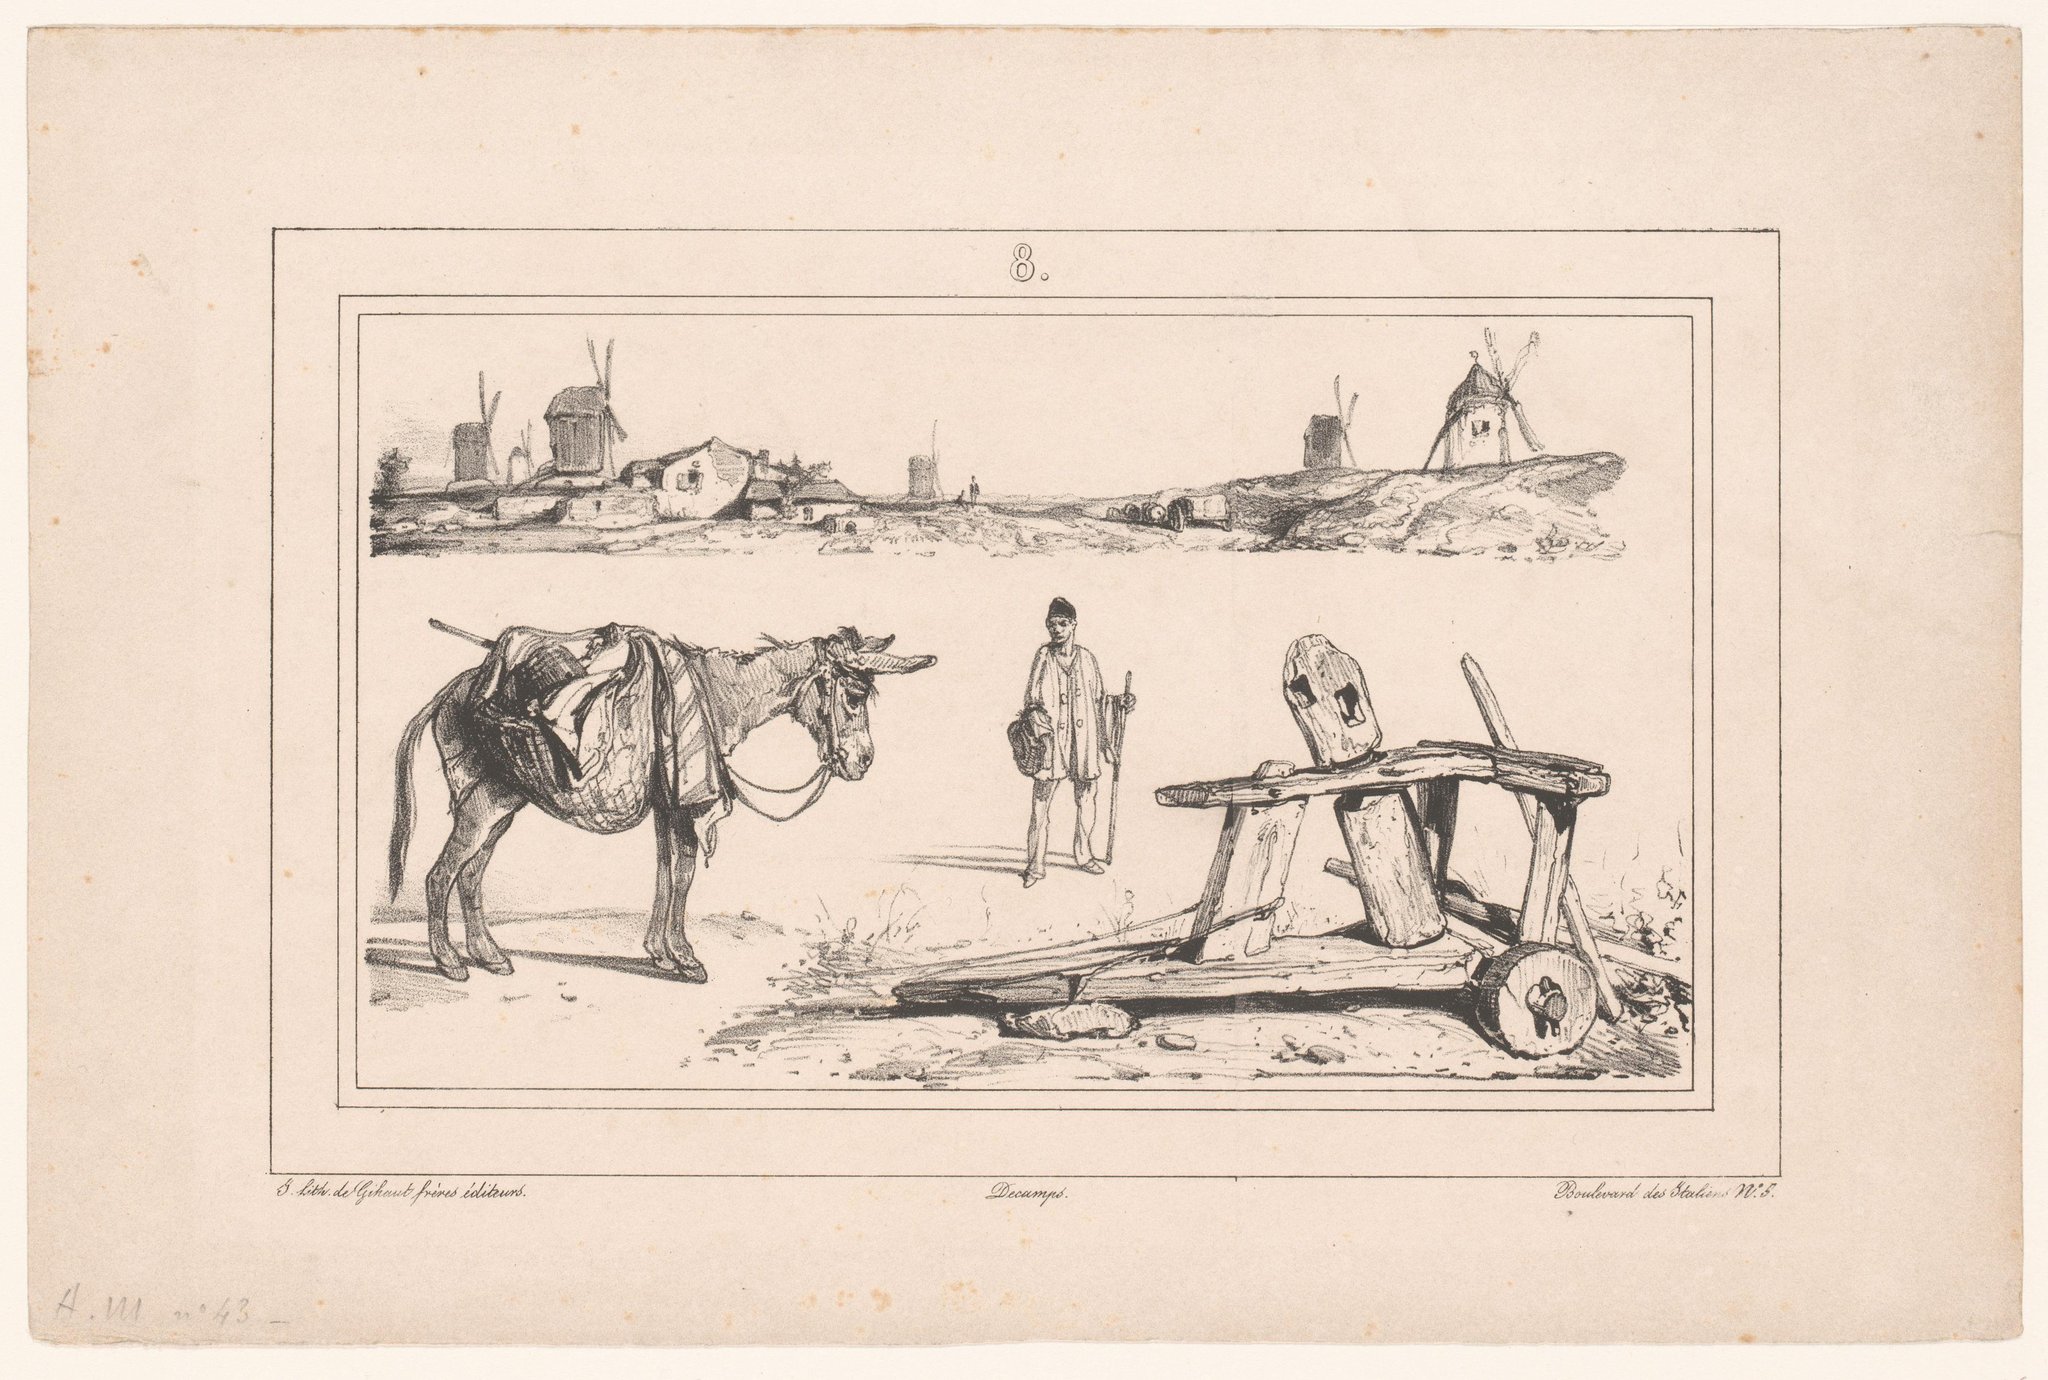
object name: print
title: Schetsen van het alledaagse leven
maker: alexandre-gabriel decamps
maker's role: draughtsman, painter, print maker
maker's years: 1803-1860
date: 1830-1831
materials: paper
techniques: lithograph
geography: paris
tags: ass, donkey, windmill in landscape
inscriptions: collector's mark: Lugt 2228a, collector's mark: Lugt 2760